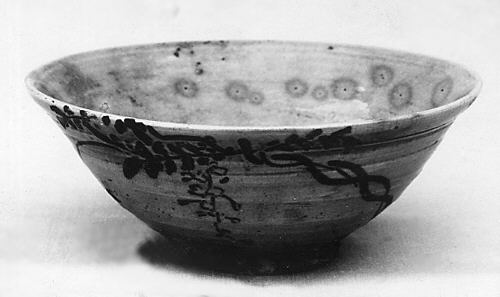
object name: teabowl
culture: japanese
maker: kiyomizu rokubei iii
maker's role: artist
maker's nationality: japanese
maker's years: 1820-1880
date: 1801-1900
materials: clay, glaze